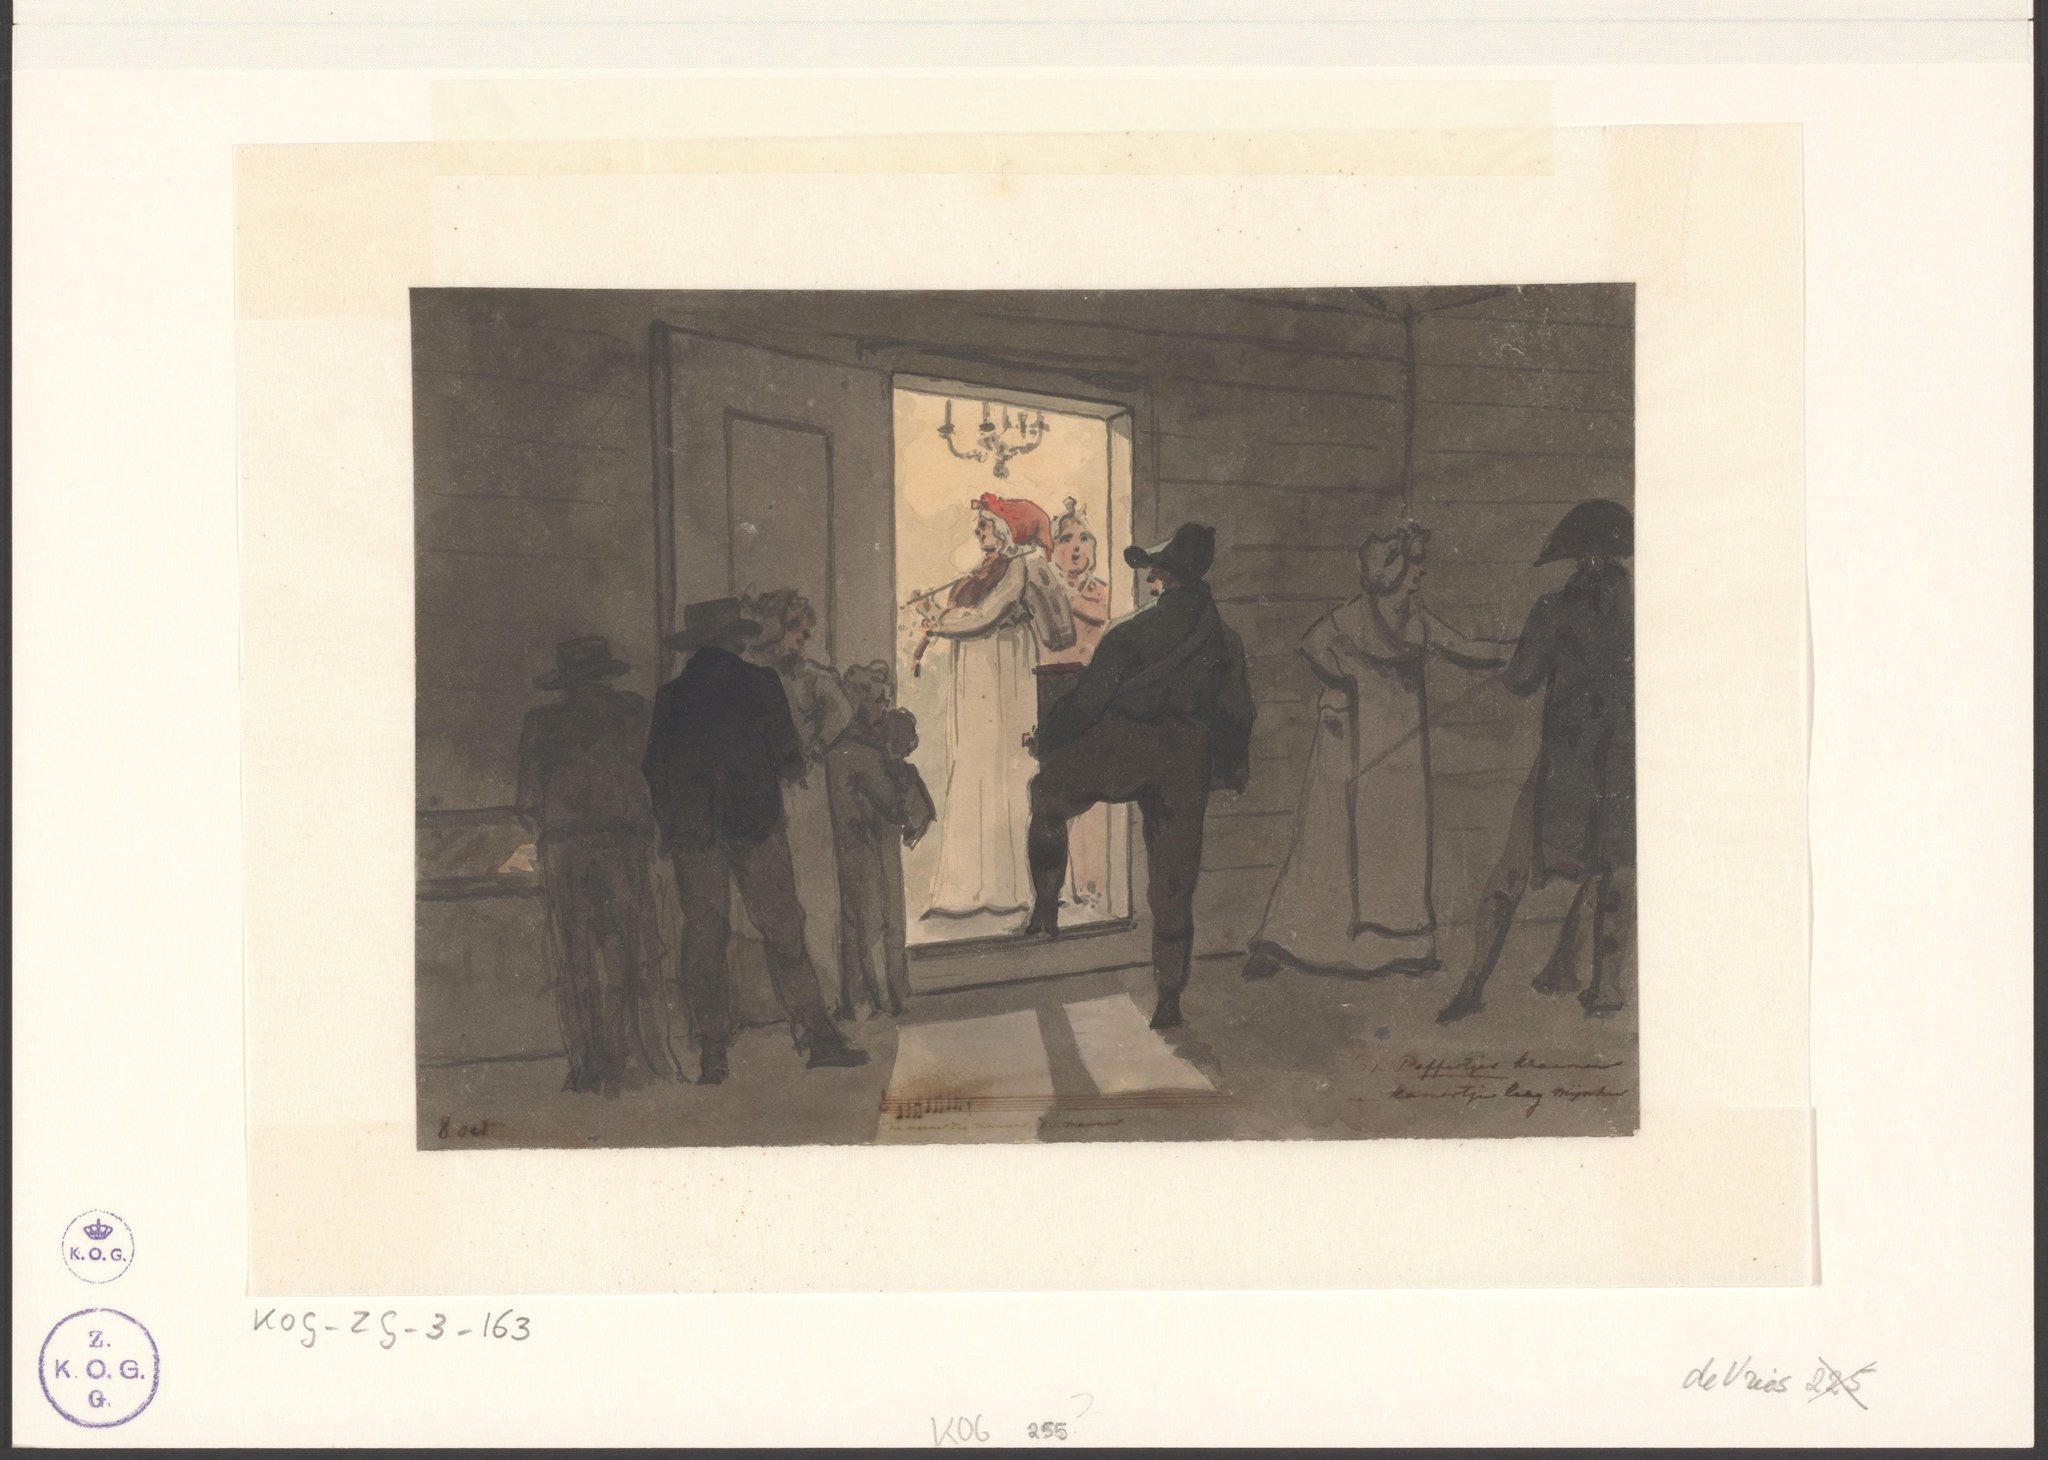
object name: drawing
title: Poffertjeskraam op de kermis met een man met buikorgel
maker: christiaan andriessen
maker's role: draughtsman, print maker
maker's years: 1775-1846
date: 1806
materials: ink, paper, pencil, watercolor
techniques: brush, pen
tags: pancakes, persons engaged in trade and commerce - bb - women engaged in trade and commerce, pleasure fair and circus, amsterdam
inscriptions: collector's mark: Lugt 1641a, inscription: ‘8 oct de Poffertjes kraamen een kamertje leeg mijnheer’, collector's mark: Lugt 1641, signature: ‘J Andriessen’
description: Een poffertjeskraam op de kermis bij avond. In de deuropening een man met een buikorgel en in de verlichte ruimte binnen twee vrouwelijke muzikanten. Onderaan op het blad is een notenbalk met melodie.